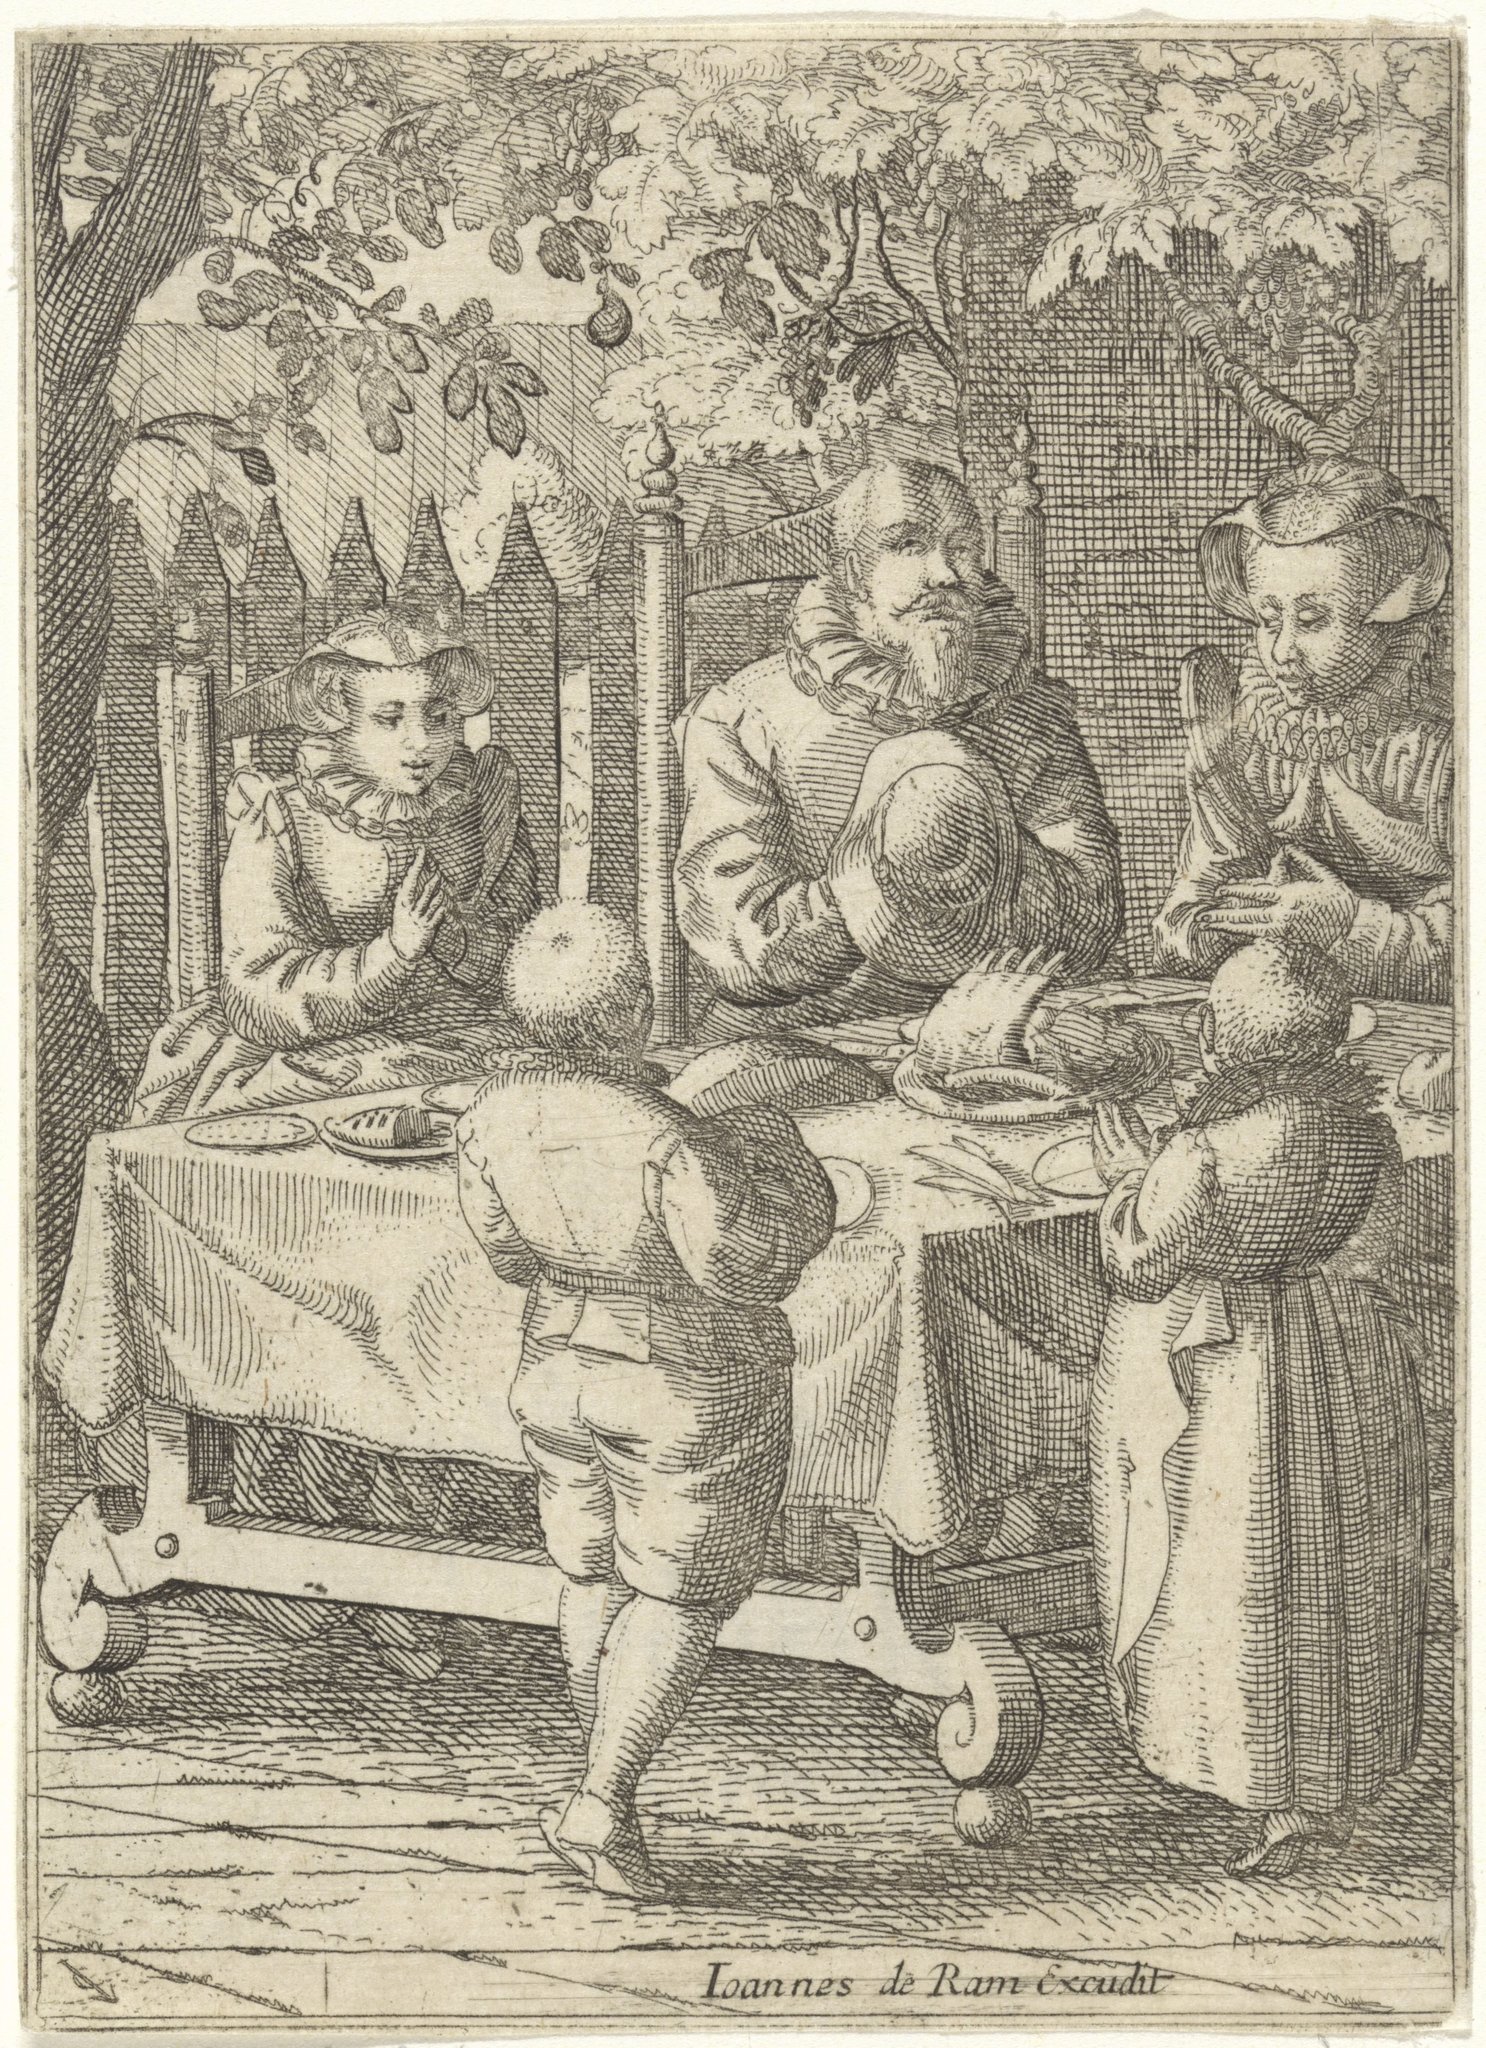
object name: print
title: Gebed voor de maaltijd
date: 1608-1610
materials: paper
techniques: engraving, etching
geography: amsterdam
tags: the book of psalms (with book chapter:verse), cradle, crib, illustration ~ printed matter, book, prayer at table, saying grace, dining-room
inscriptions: monogram: ‘CIV’, collector's mark: Lugt 2228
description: In een kleine tuin onder de bomen zit een gezin aan een gedekte tafel te bidden voor het eten. De ouders en de oudste dochter zitten. Twee kleine kinderen, op de rug gezien, staan.